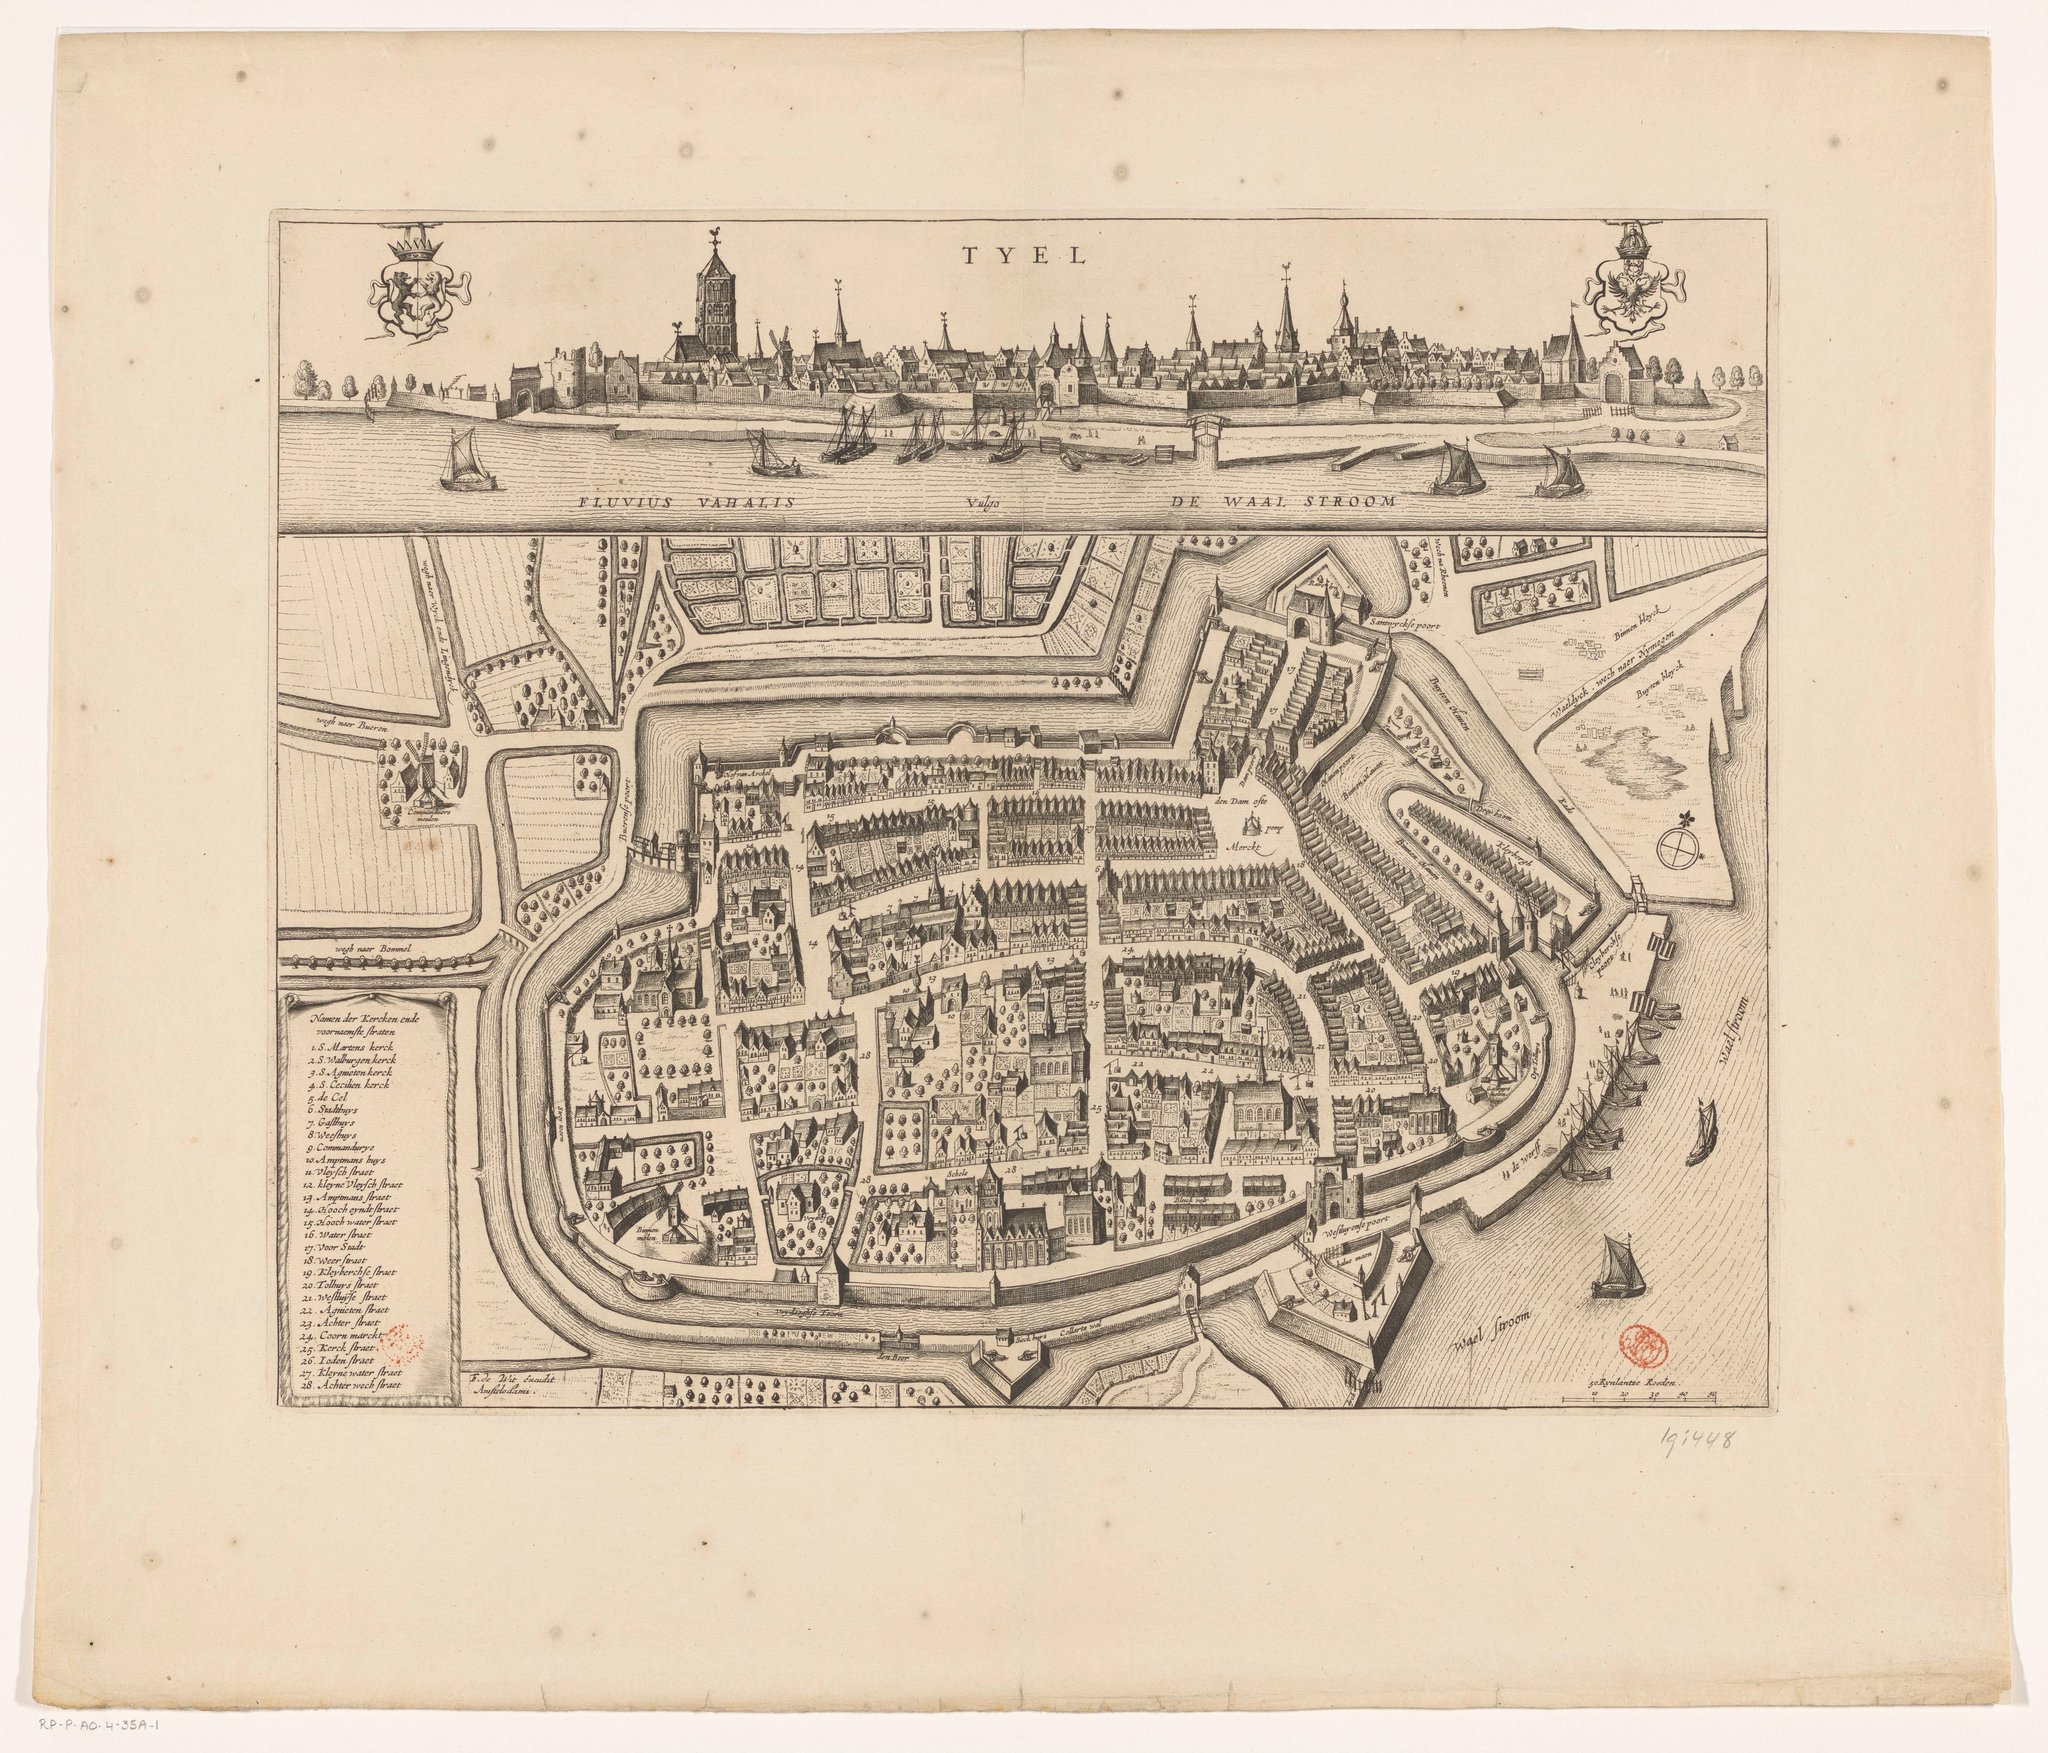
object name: area plan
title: Tyel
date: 1657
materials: paper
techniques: engraving, etching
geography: amsterdam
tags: coat of arms (as symbol of the state, etc.), city-view, and landscape with man-made constructions, maps of cities, gelderland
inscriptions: collector's mark: Lugt 195, collector's mark: Lugt 2233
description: Bovenaan een stadsgezicht van Tiel met daarop links het wapen van Gelderland en rechts dat van Tiel. Daaronder een plattegrond van de stad in vogelvluchtperspectief. Linksonder op de plattegrond een legenda, rechtsonder een schaalstok: 50 Rynlantse roeden.